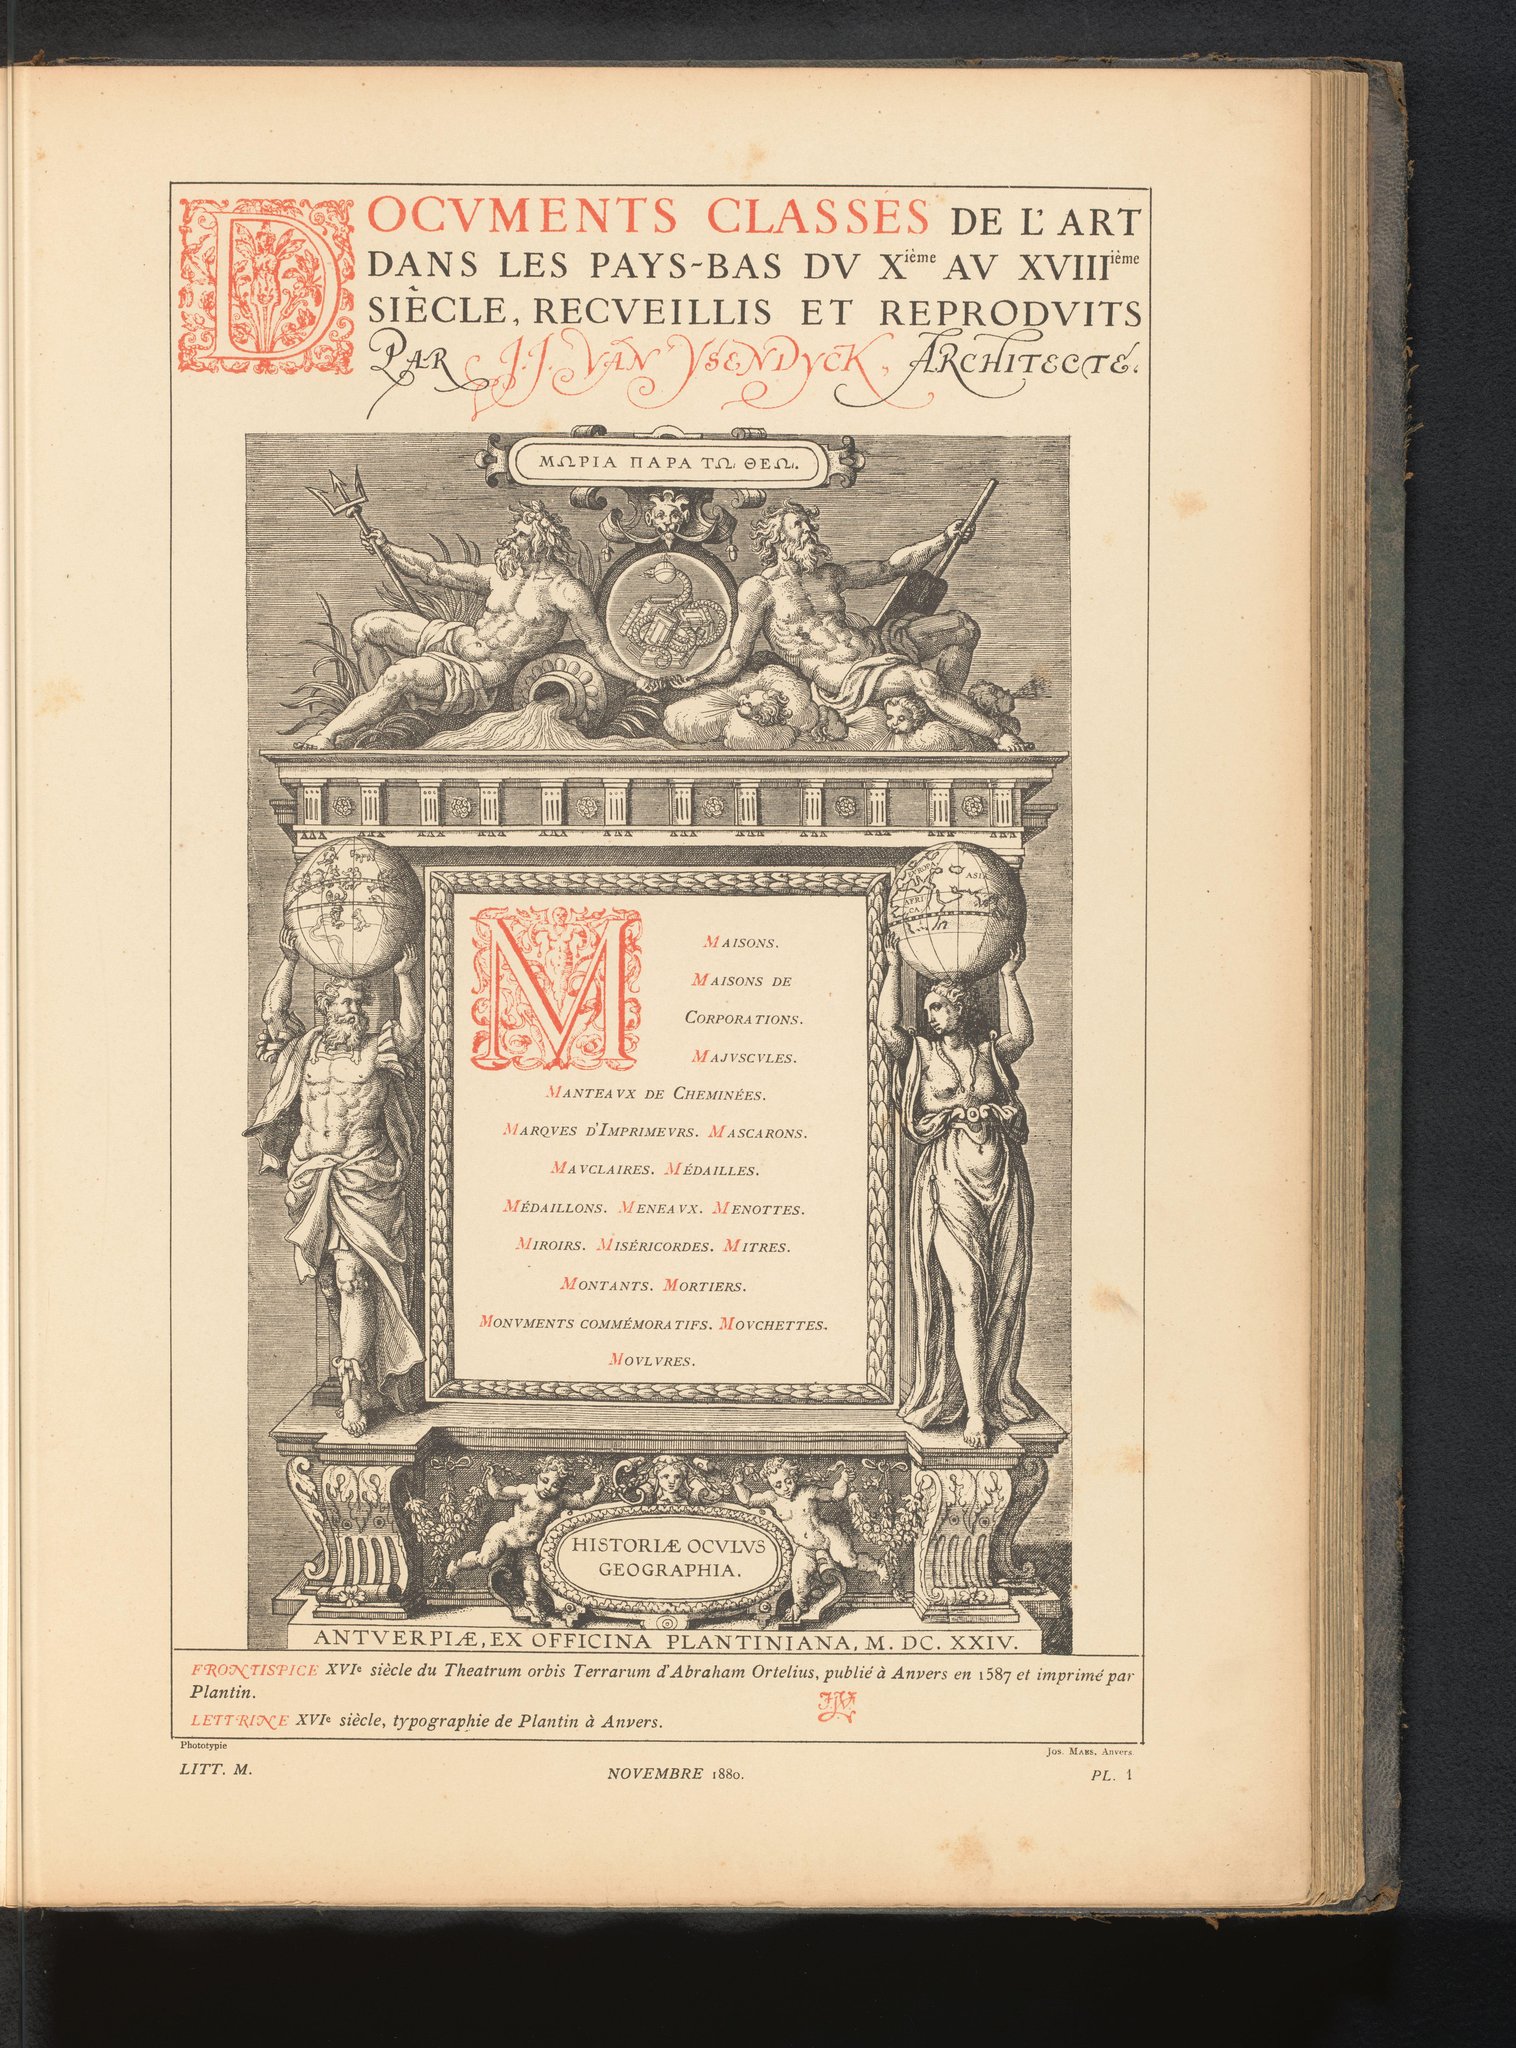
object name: reproduction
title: Reproductie van een titelpagina uit het Theatrum orbis Terrarum van Abraham Ortelius, met Jupiter, Juno, Neptunus en andere figuren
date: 1875-1880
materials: paper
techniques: photolithography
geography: antwerp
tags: (story of) neptune (poseidon), (story of) juno (hera), (story of) jupiter (zeus), title-page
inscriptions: inscription: ‘FRONTISPICE XVIe siècle (...)’, monogram: ‘JJvY’, inscription: ‘LITT. M. - NOVEMBRE 1880. - PL. 1’